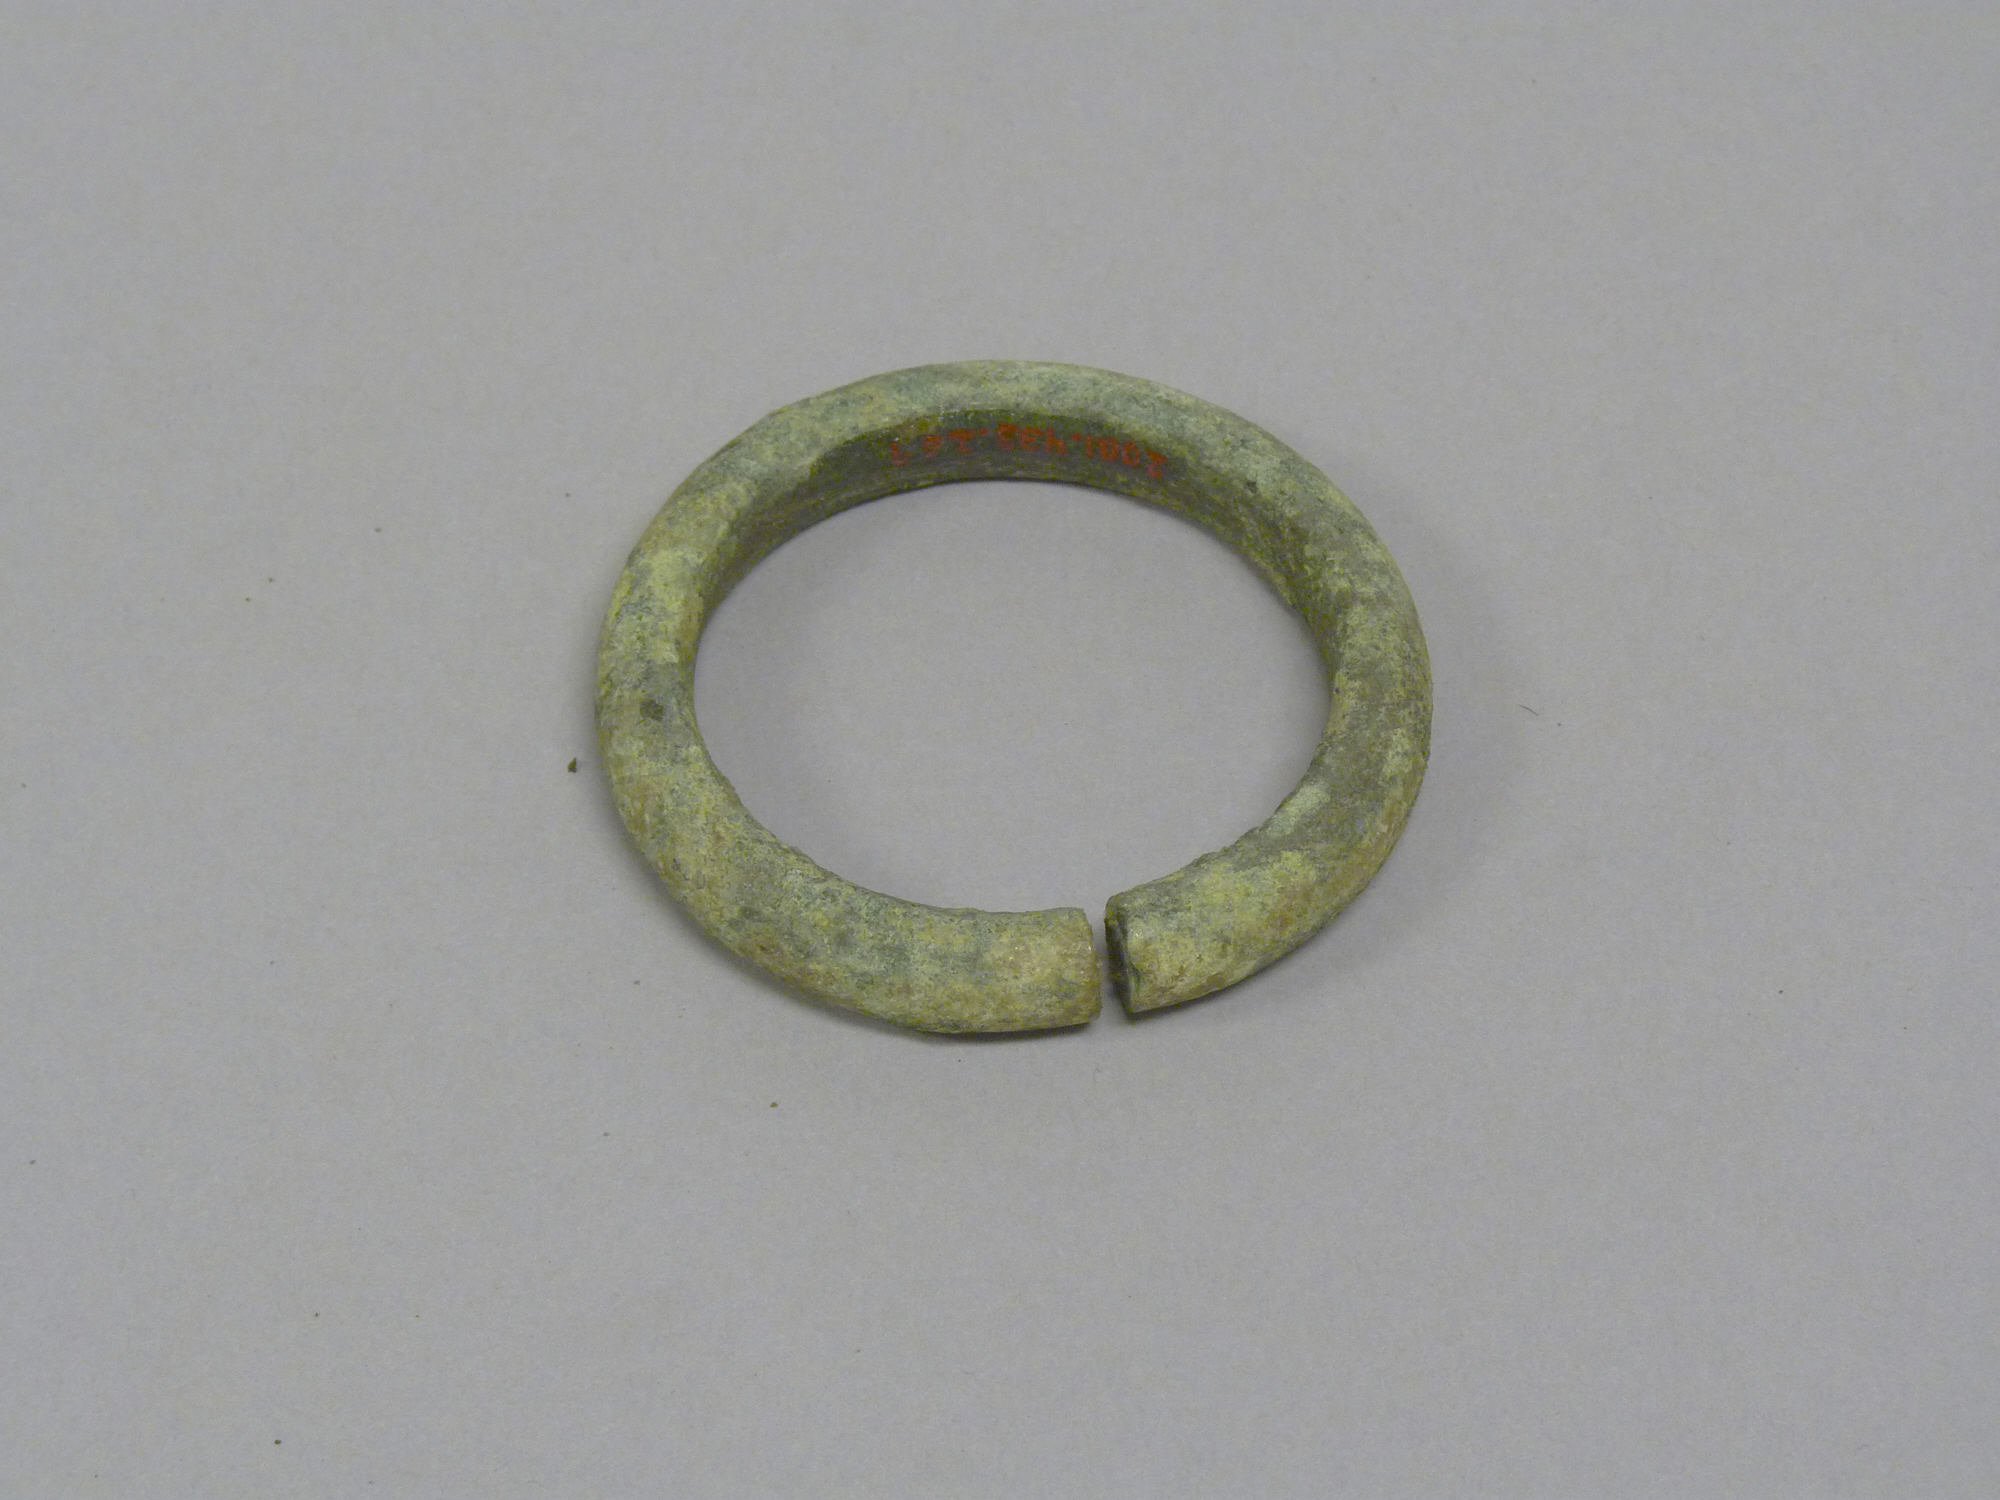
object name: solid undecorated bangle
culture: thai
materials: bronze